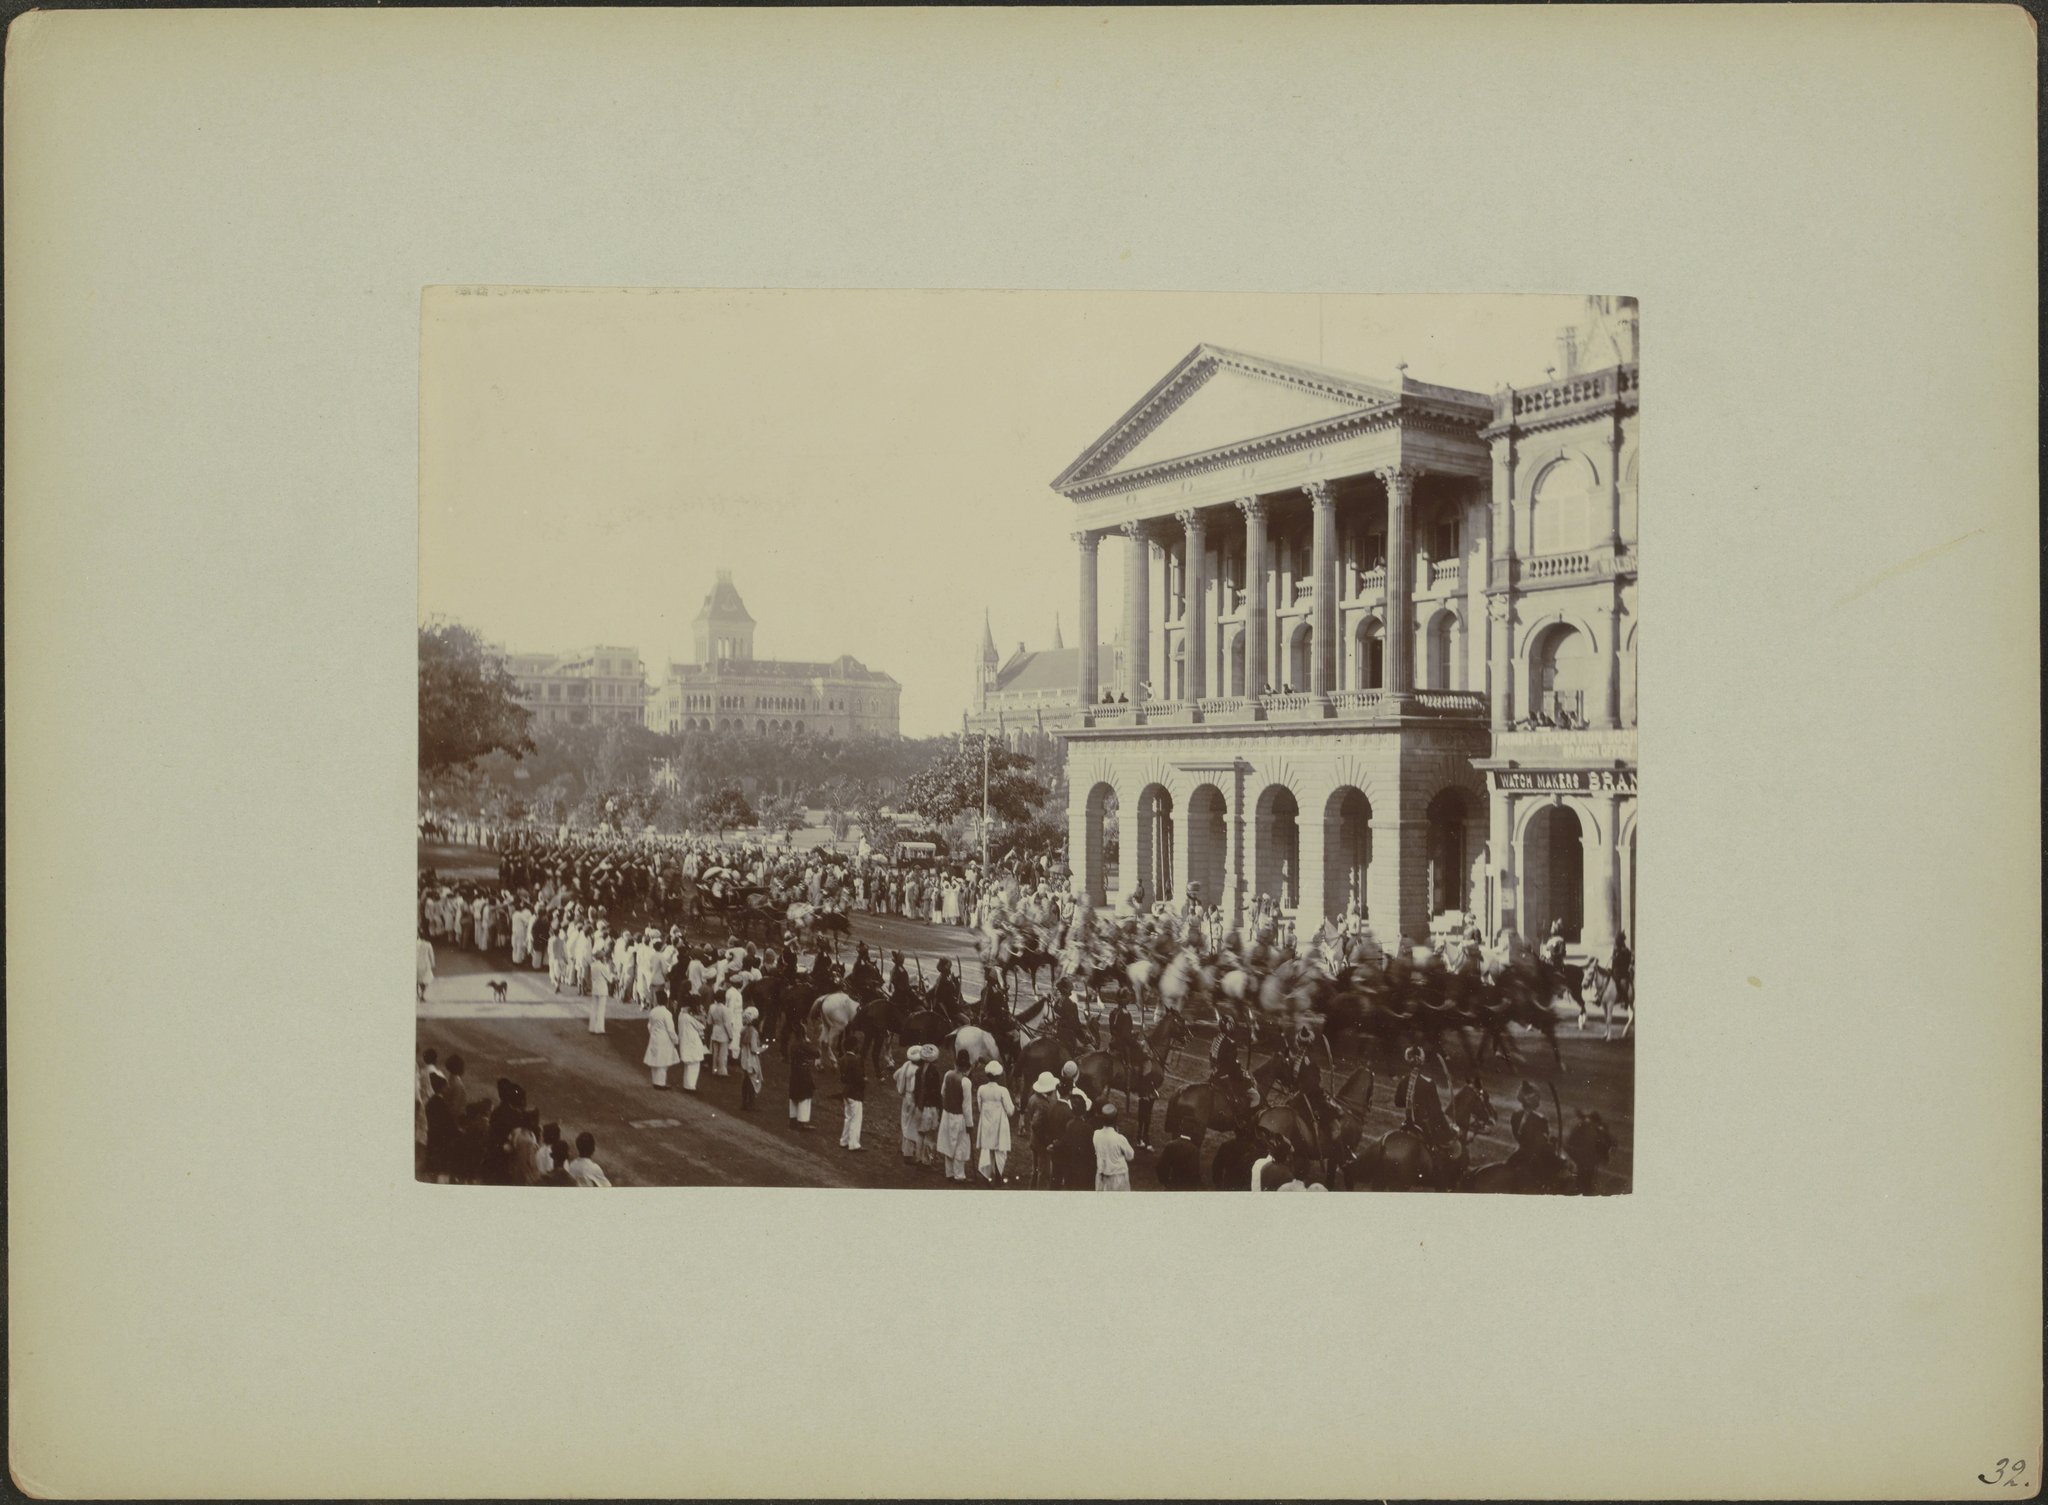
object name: photograph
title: Ruiterstoet en publiek op straat in Bombay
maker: Anonymous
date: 1870-1910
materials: cardboard, paper, photographic support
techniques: gelatin silver print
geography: mumbai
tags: land forces (+ cavalry, horsemen), festivities (+ parade, pageant, cavalcade ~ festive activities), street (+ city(-scape) with figures, staffage)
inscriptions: inscription: ‘Bombay’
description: Onderdeel van Reisalbum met foto's van bezienswaardigheden in Marseille, Port Said, Aden, Bombay, Colombo, Singapore en Nederlands-Indië.